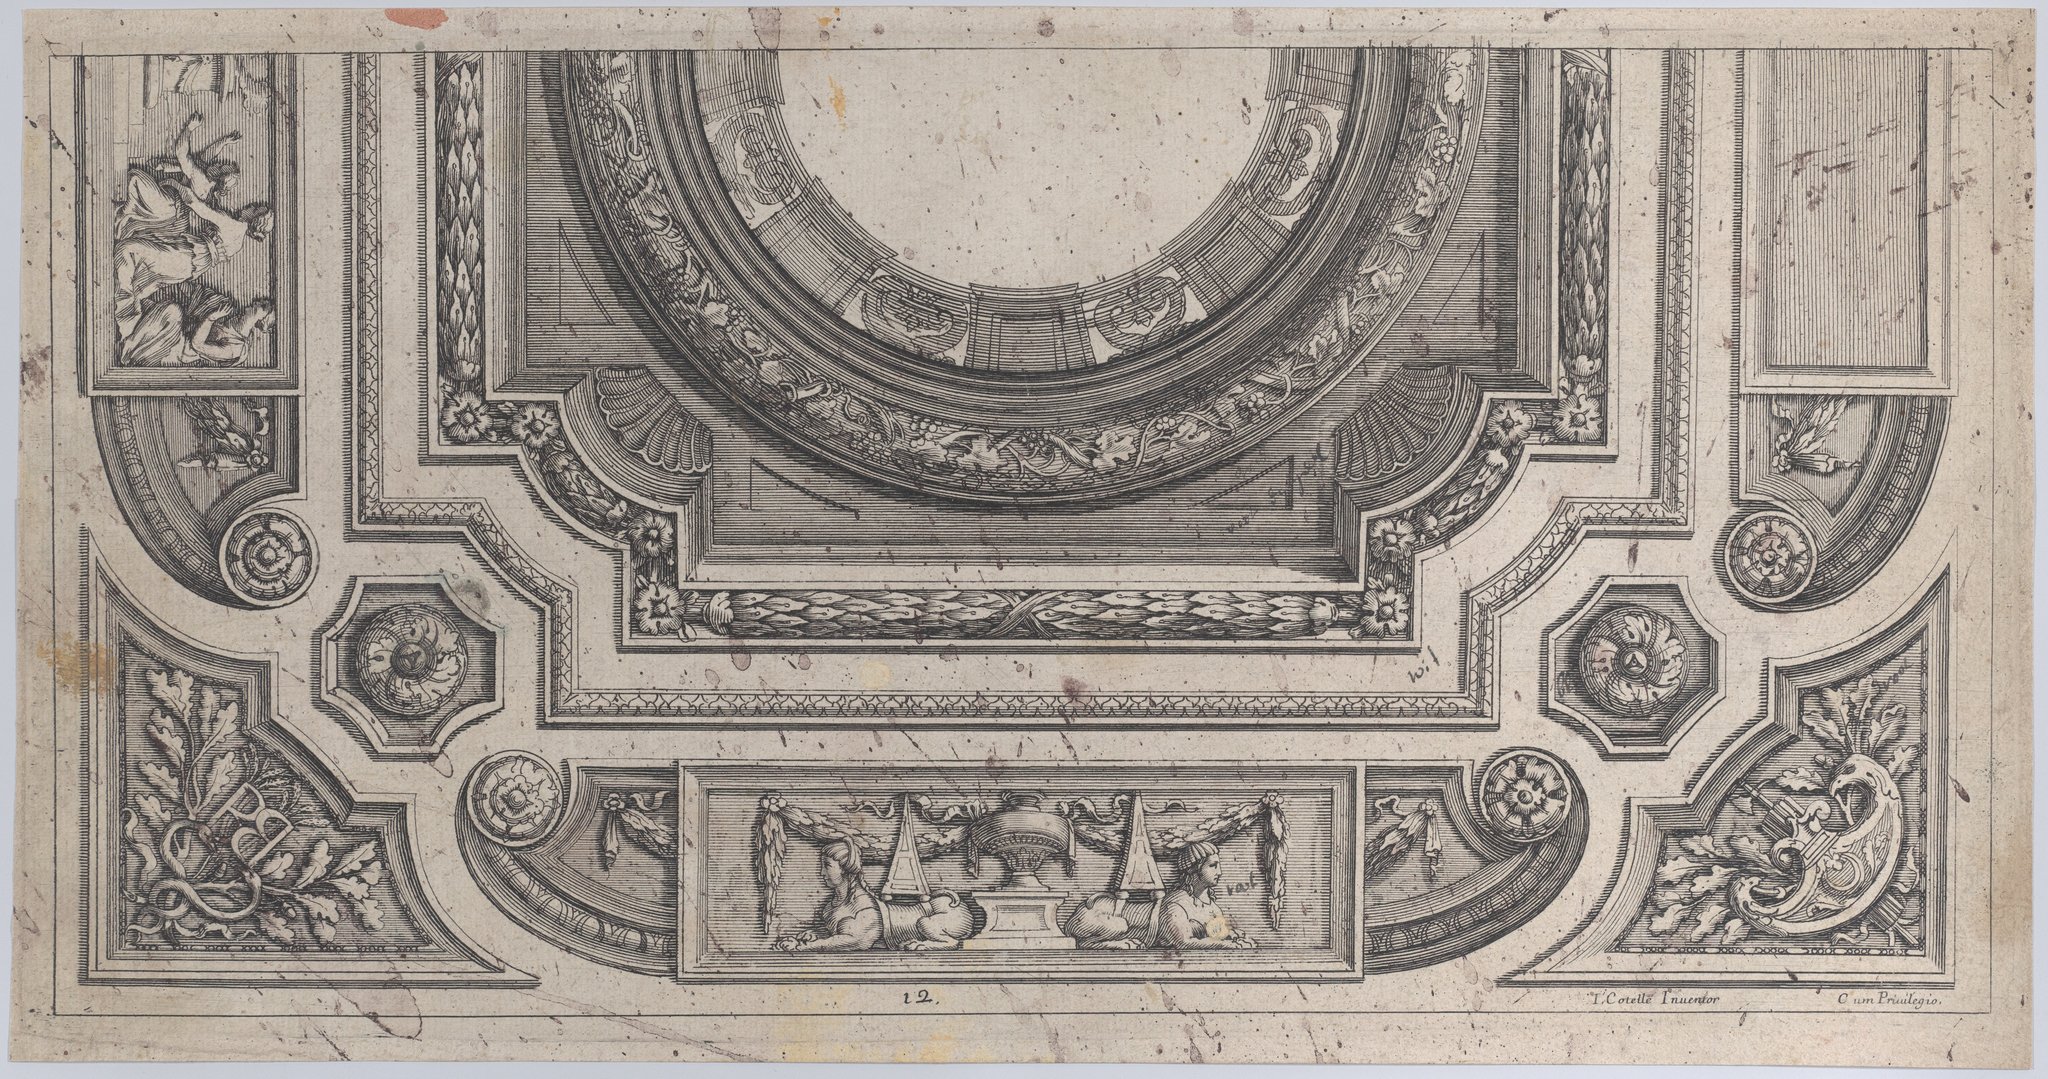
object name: print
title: Composite Order, elevation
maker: jean cotelle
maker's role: artist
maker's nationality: french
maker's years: 1642-1708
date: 1660-1708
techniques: engraving